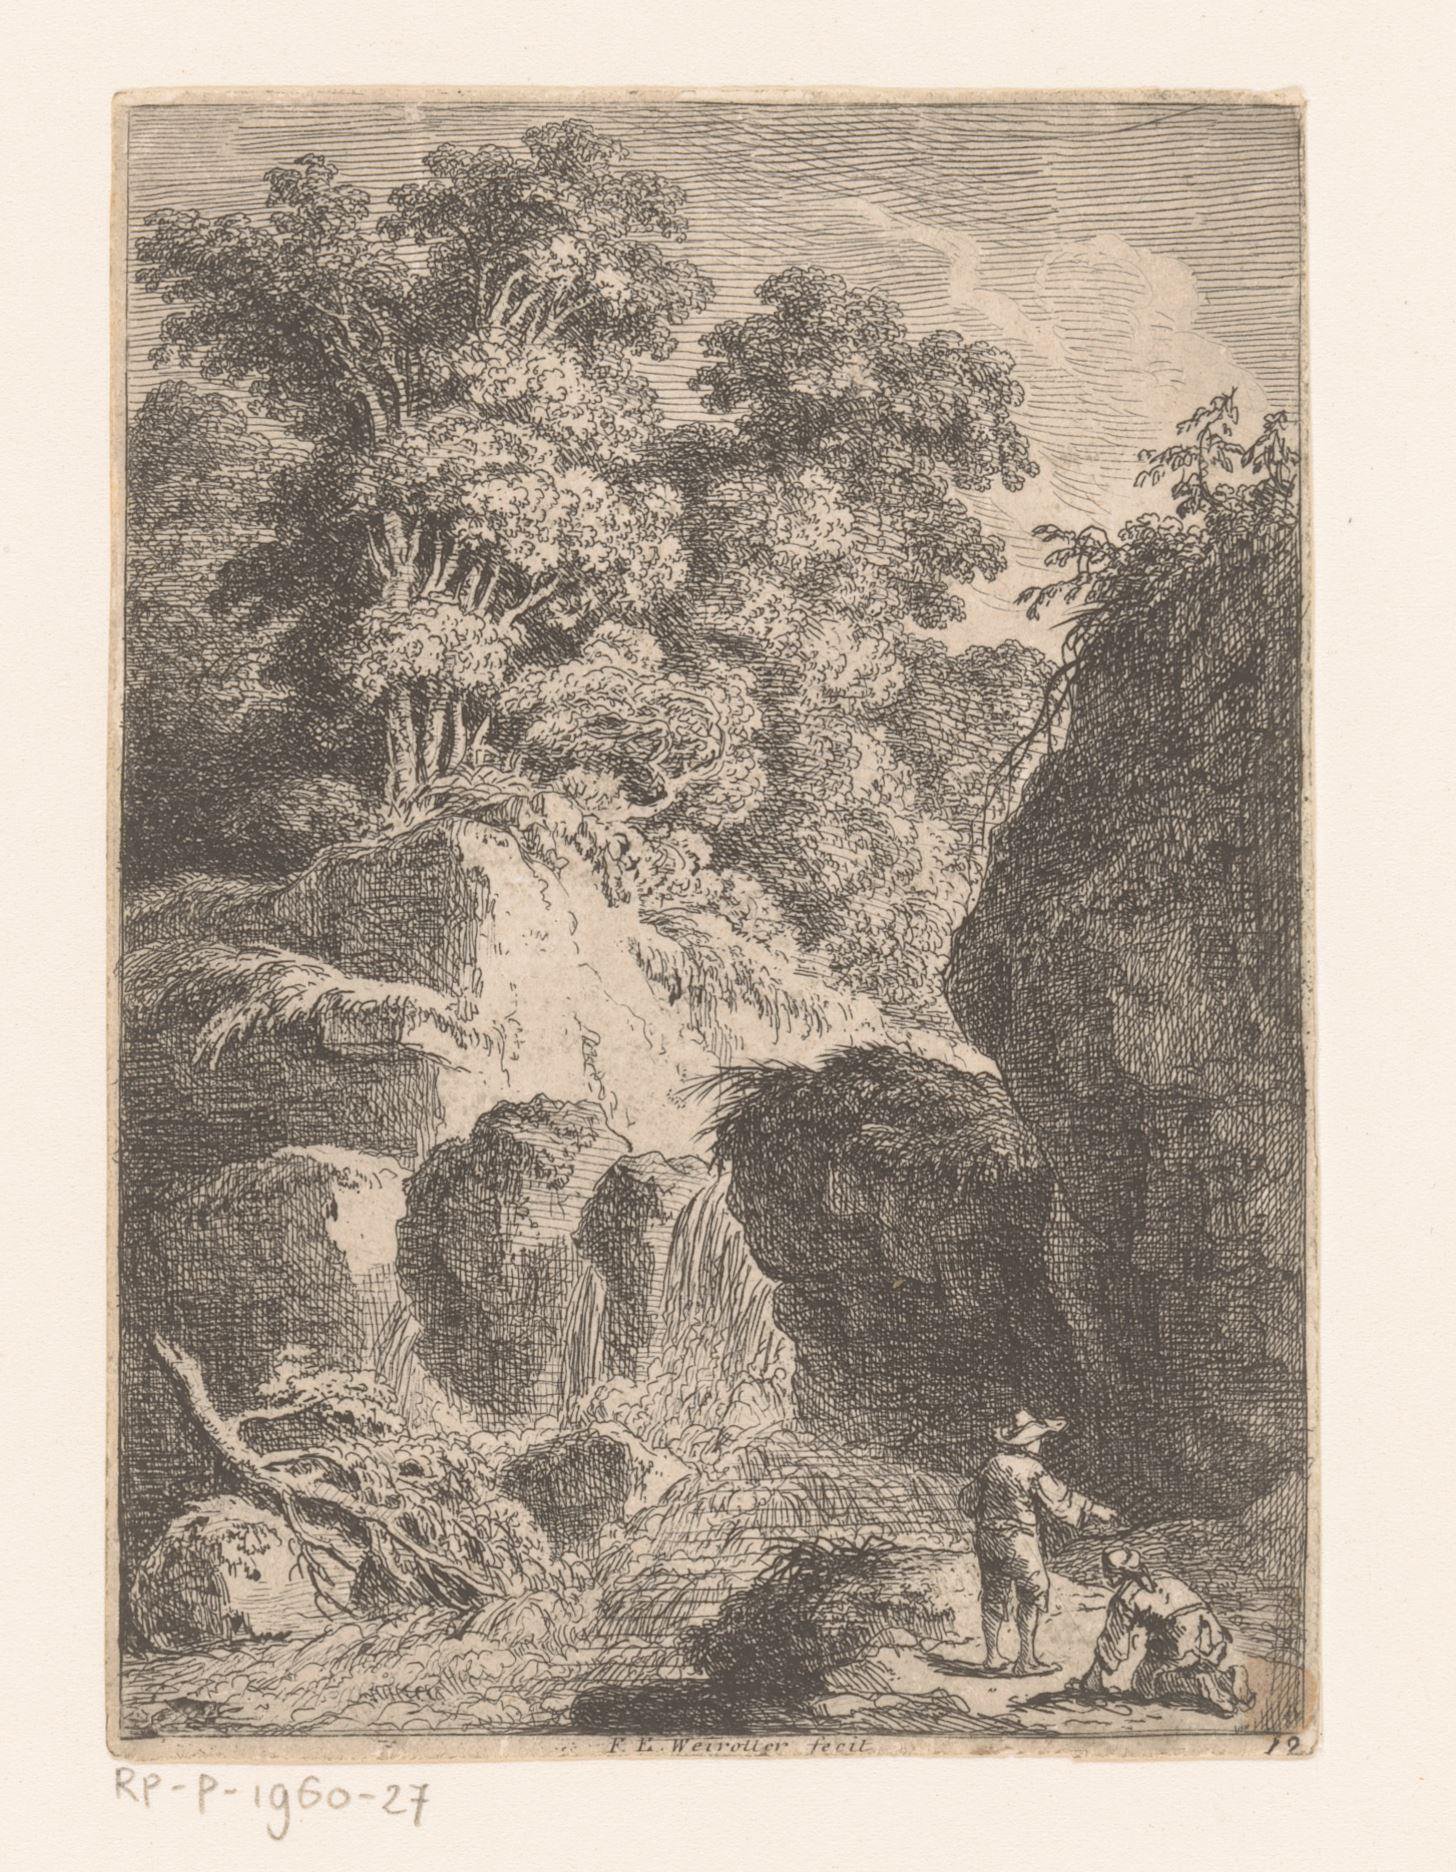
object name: print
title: Rotsachtig landschap met een waterval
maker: franz edmund weirotter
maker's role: draughtsman, painter, print maker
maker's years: 1733-1771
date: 1766-1767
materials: paper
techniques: etching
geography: vienna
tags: waterfall, rock-formations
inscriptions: collector's mark: Lugt 2228, collector's mark: Lugt 2760